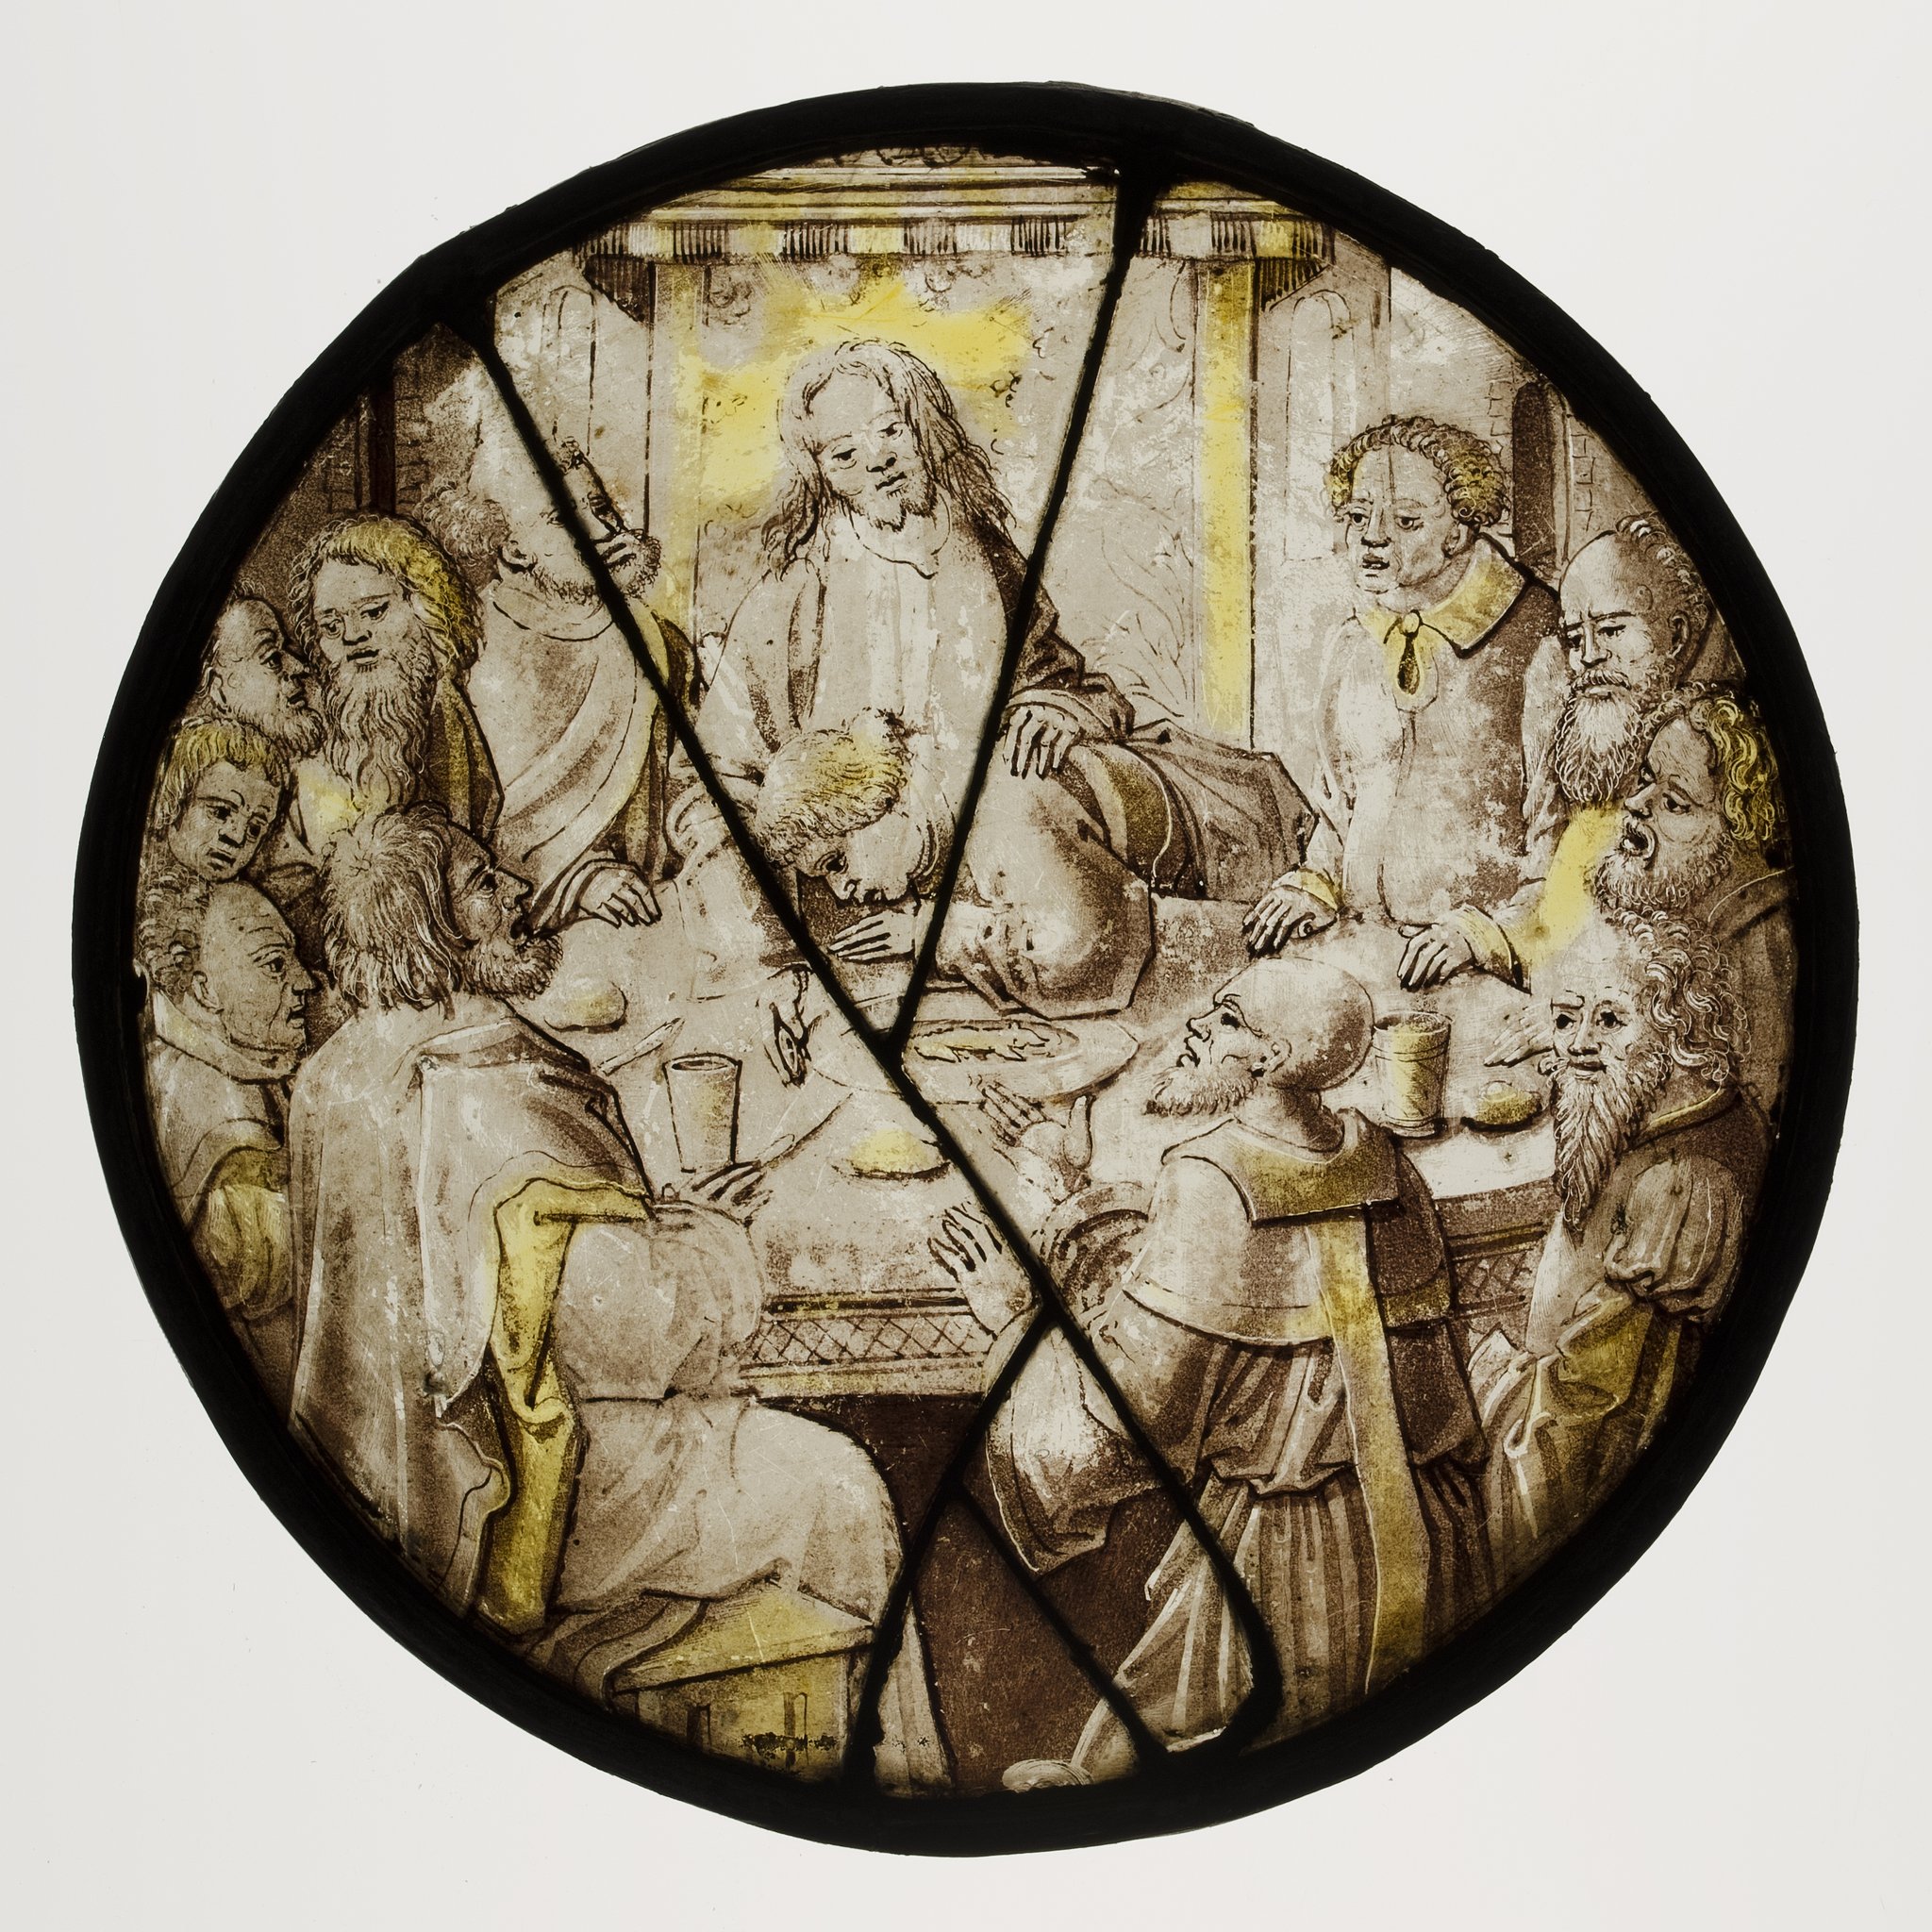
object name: roundel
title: Roundel with the Last Supper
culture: dutch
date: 1515-1525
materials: glass, paint, pigment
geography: netherlands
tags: apostles,jesus,last supper